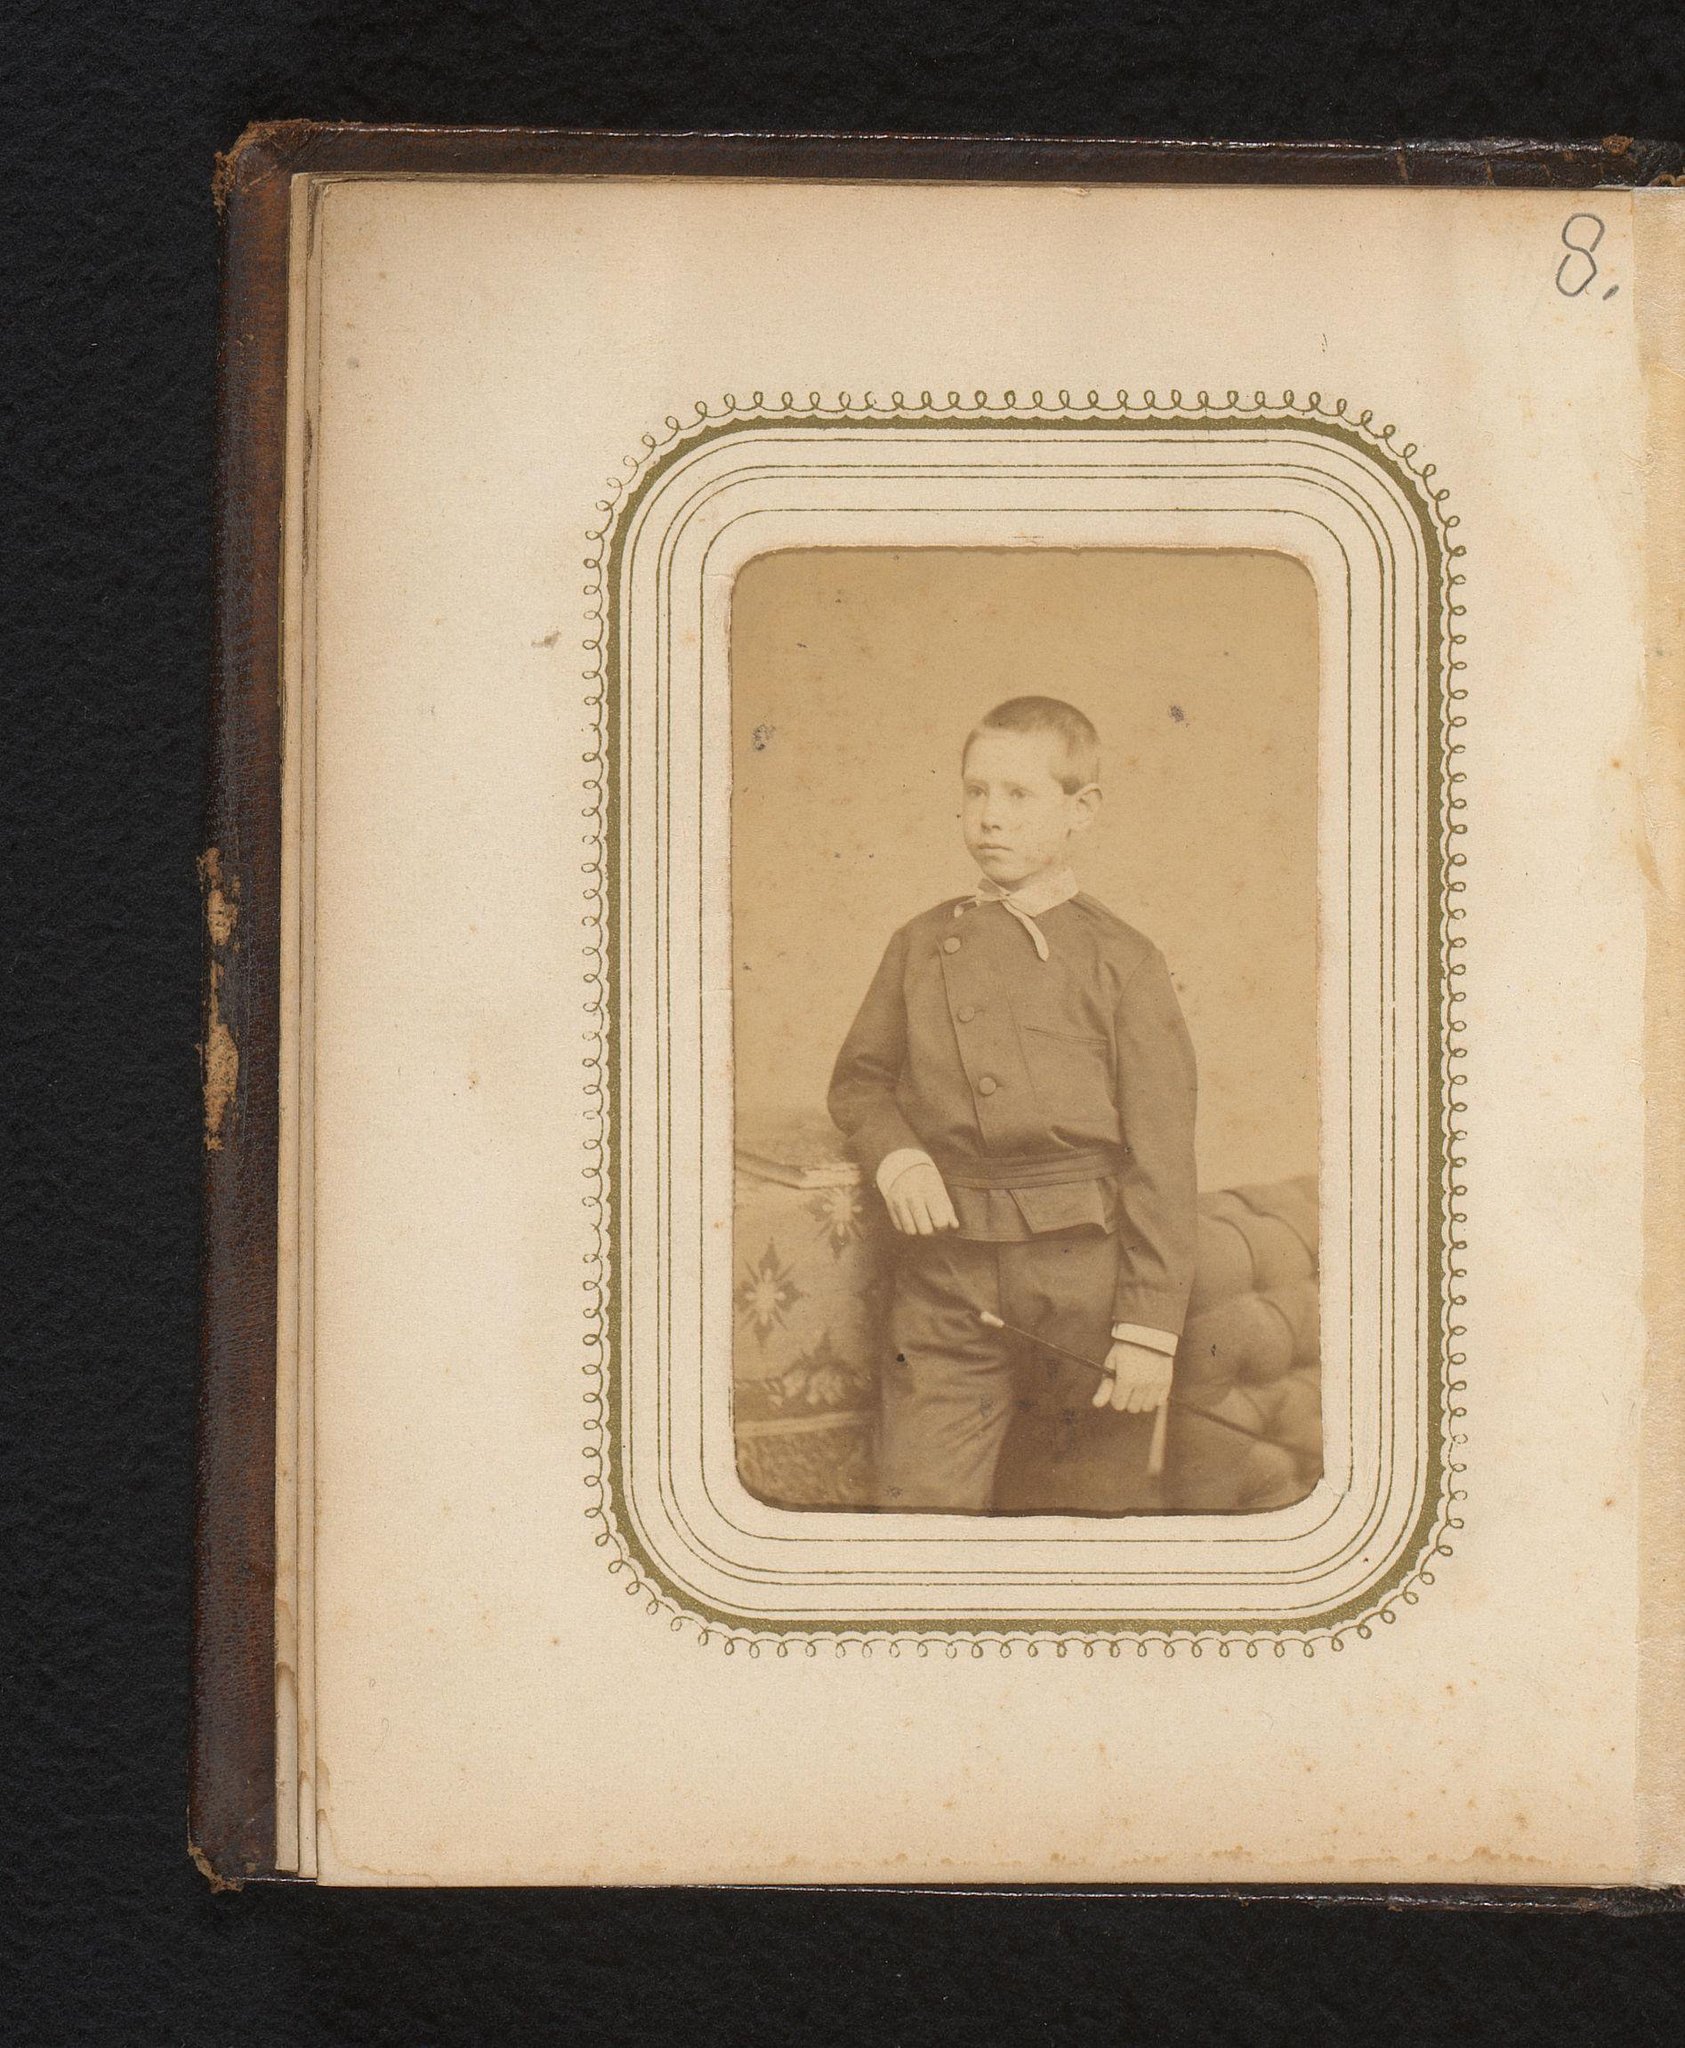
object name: album leaf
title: Portret van Alexander Buys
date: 1872-1880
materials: cardboard, paper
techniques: albumen print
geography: amsterdam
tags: historical persons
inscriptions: inscription: ‘Photogr. Atelier/ van/ Wegner & Mottu/ Kalverstraat D 26./ Amsterdam (...)’